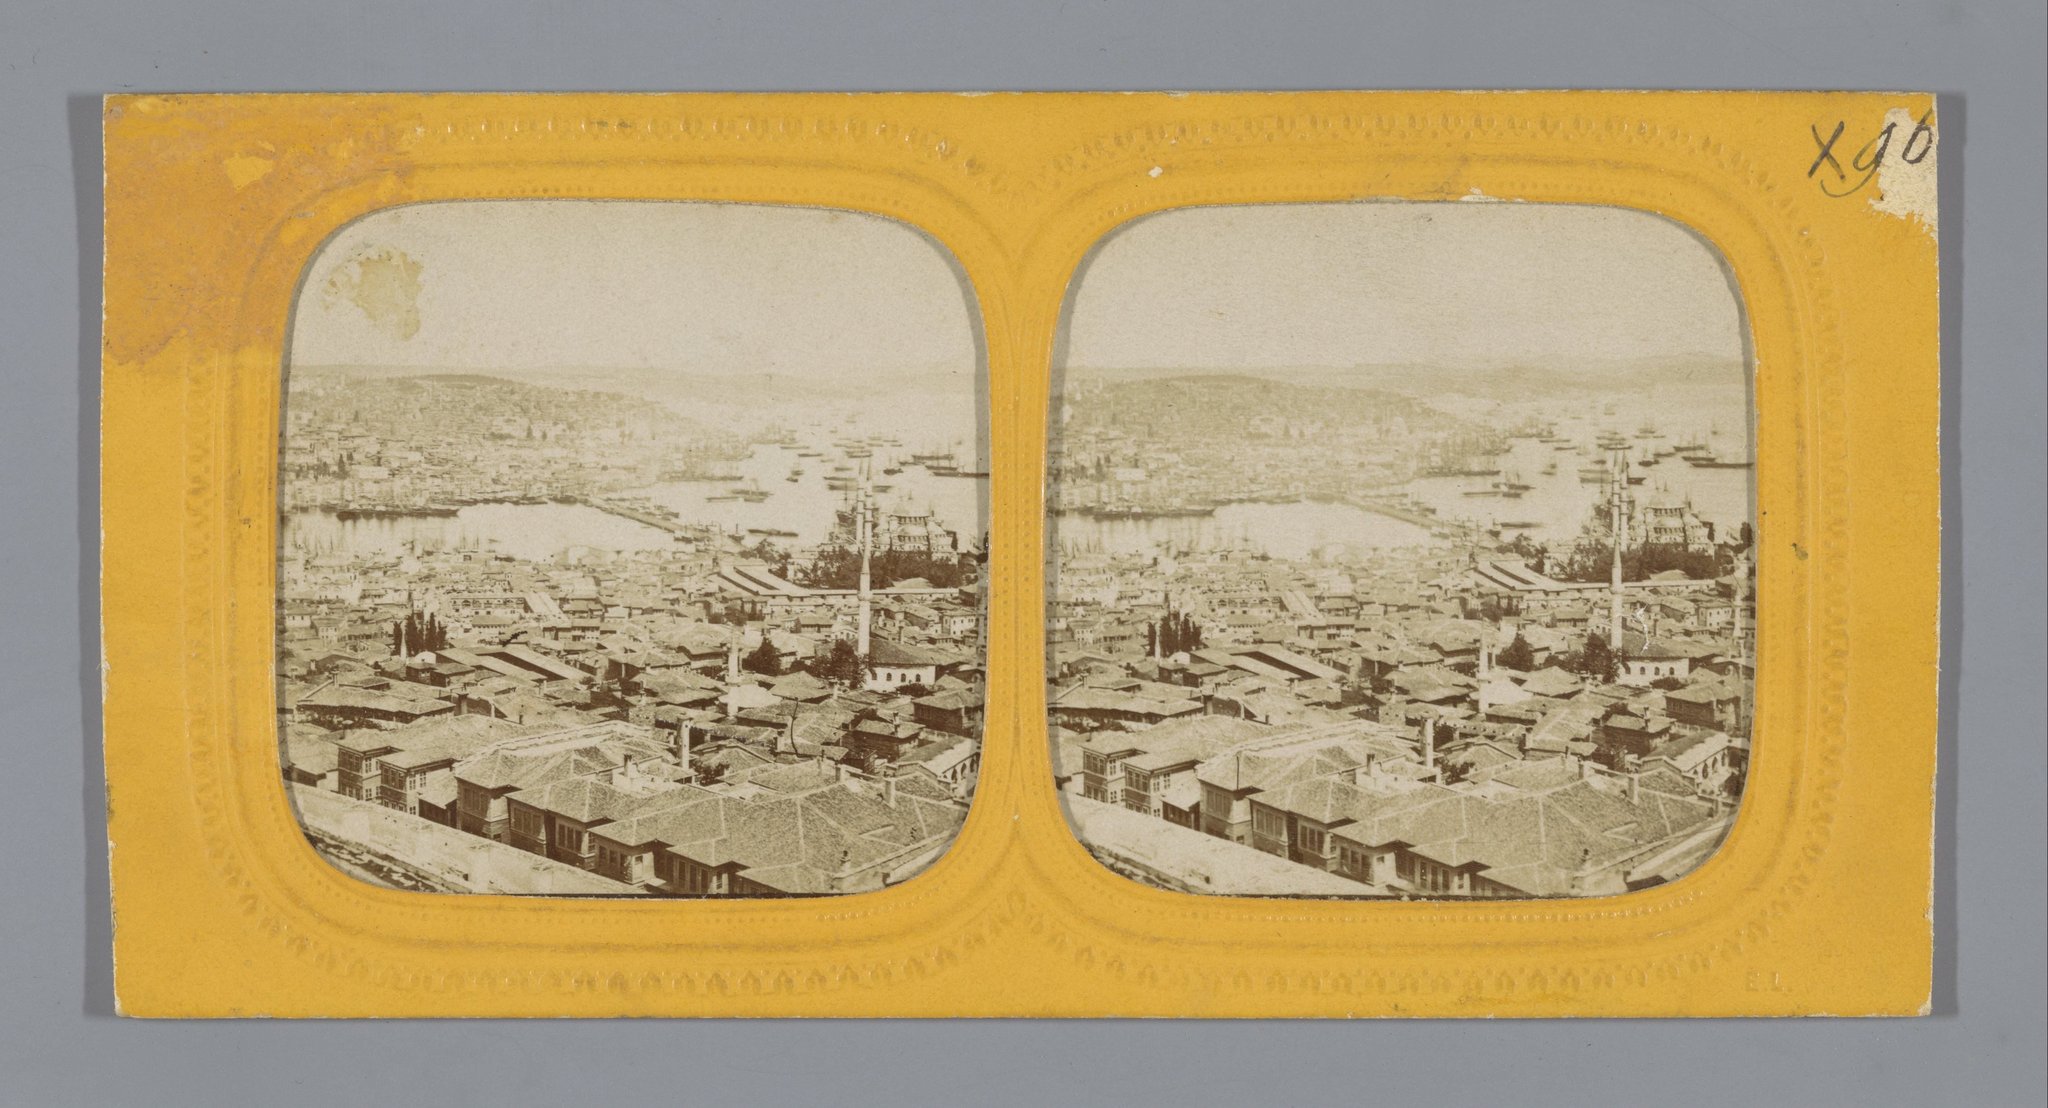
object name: tissue stereograph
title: Constantinople / Gezicht op Constantinopel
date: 1855-1875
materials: cardboard, paper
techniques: albumen print, hand coloring, perforating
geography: paris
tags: city-view in general; 'veduta'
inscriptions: inscription: ‘X90’